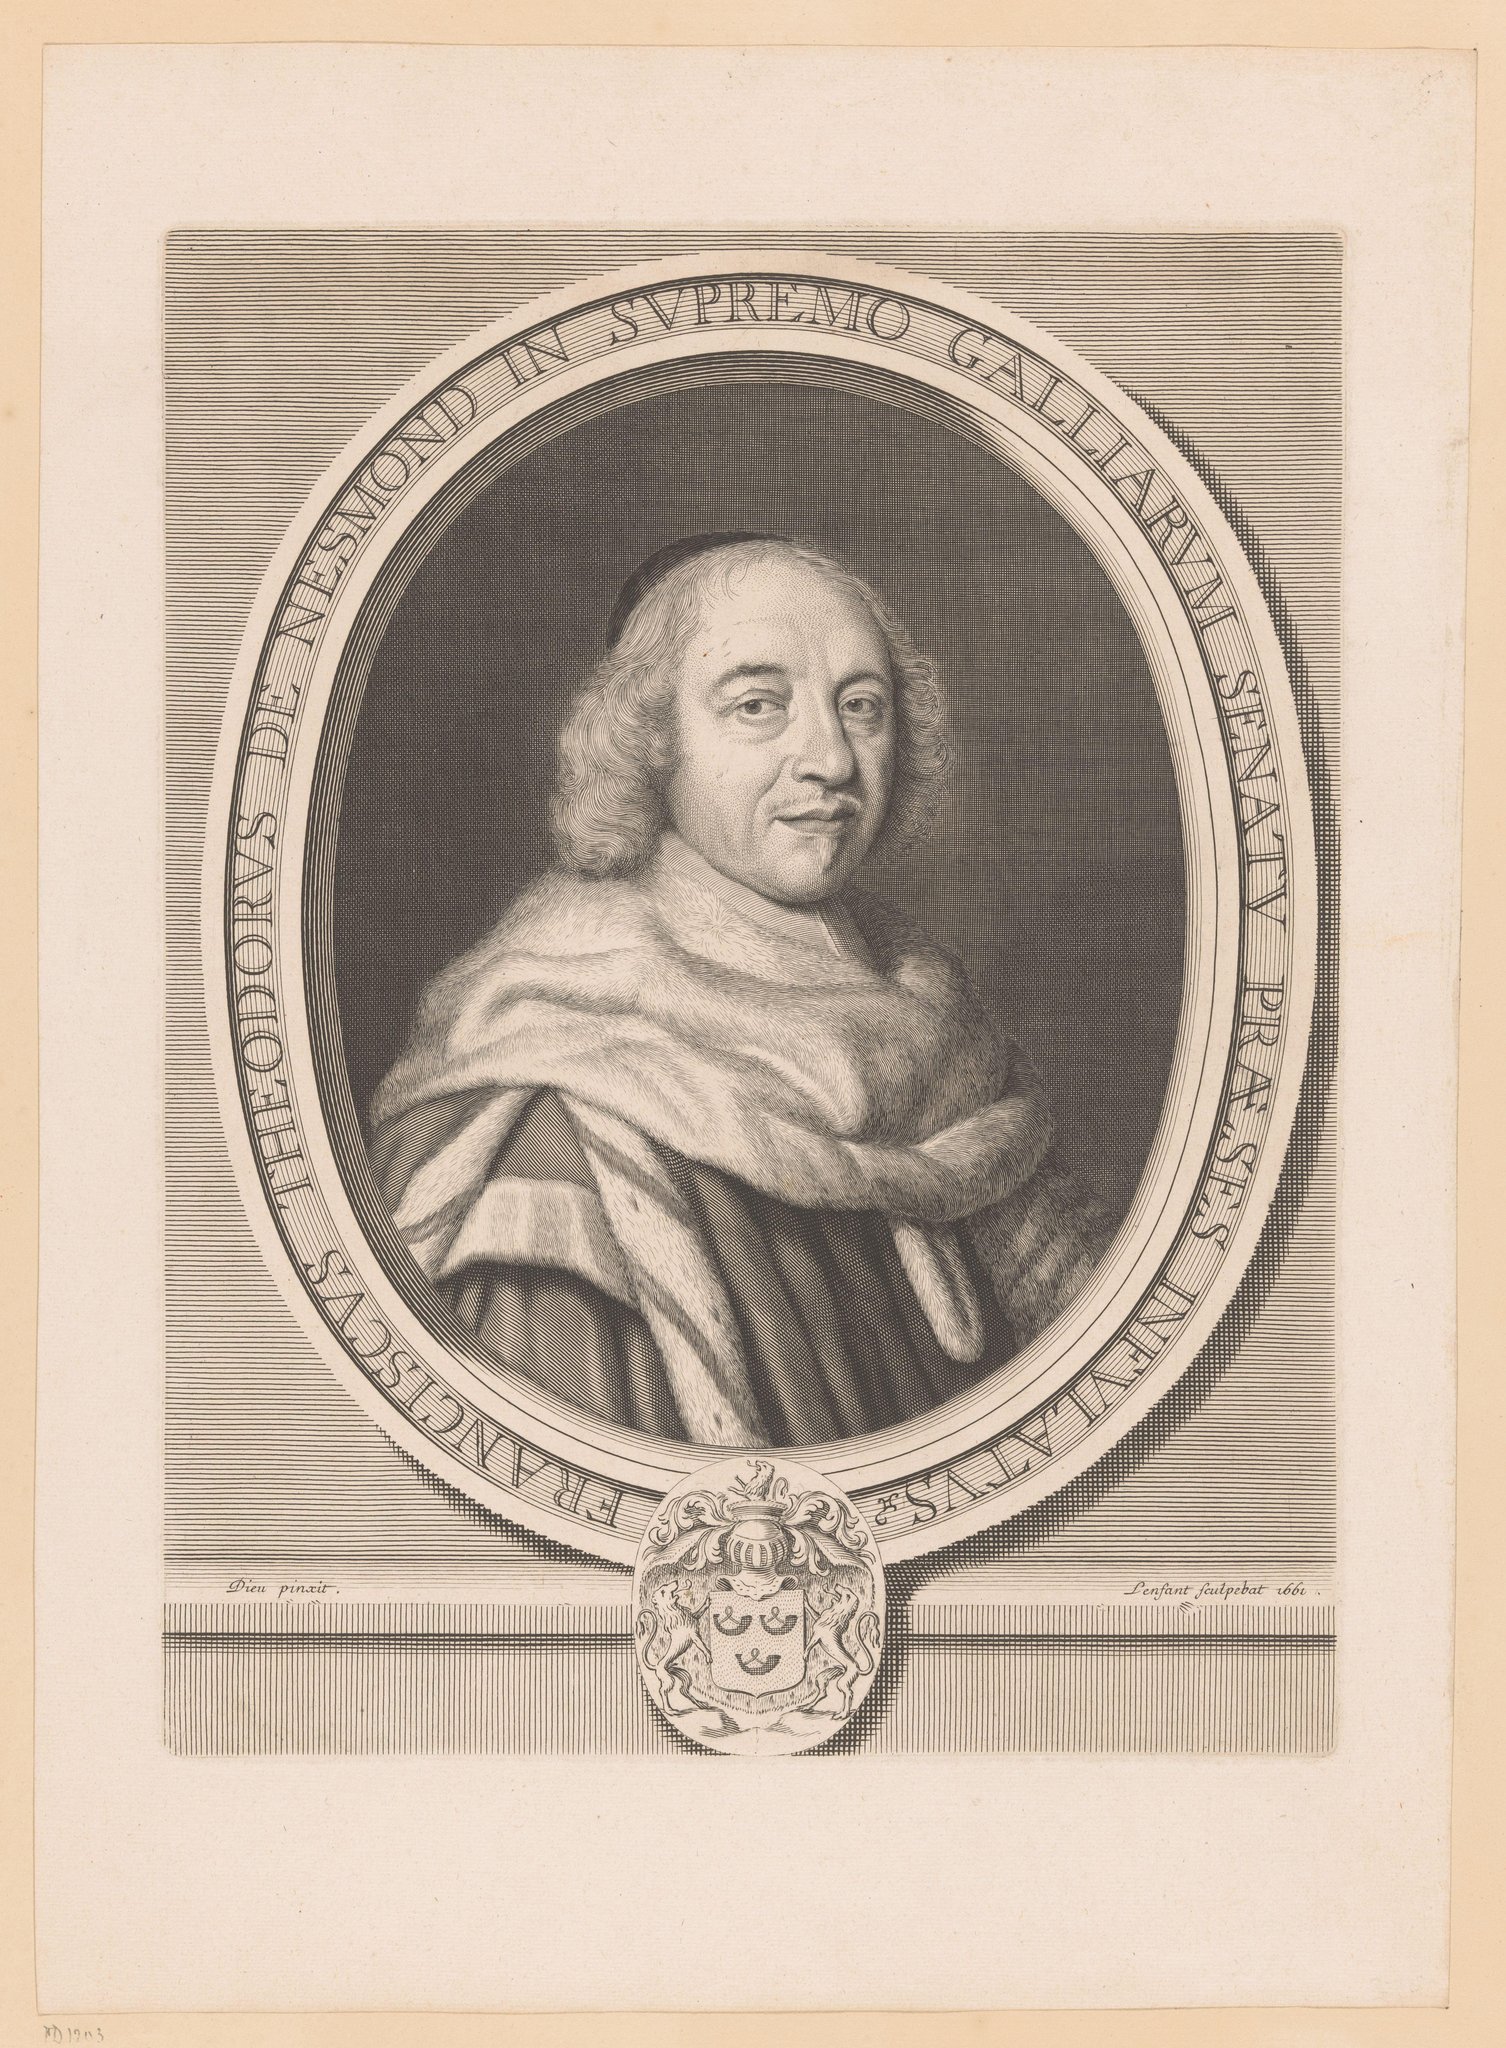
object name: print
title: Portret van François-Théodore de Nesmond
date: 1661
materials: paper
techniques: engraving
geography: france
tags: historical persons, armorial bearing, heraldry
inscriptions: collector's mark: Lugt 240